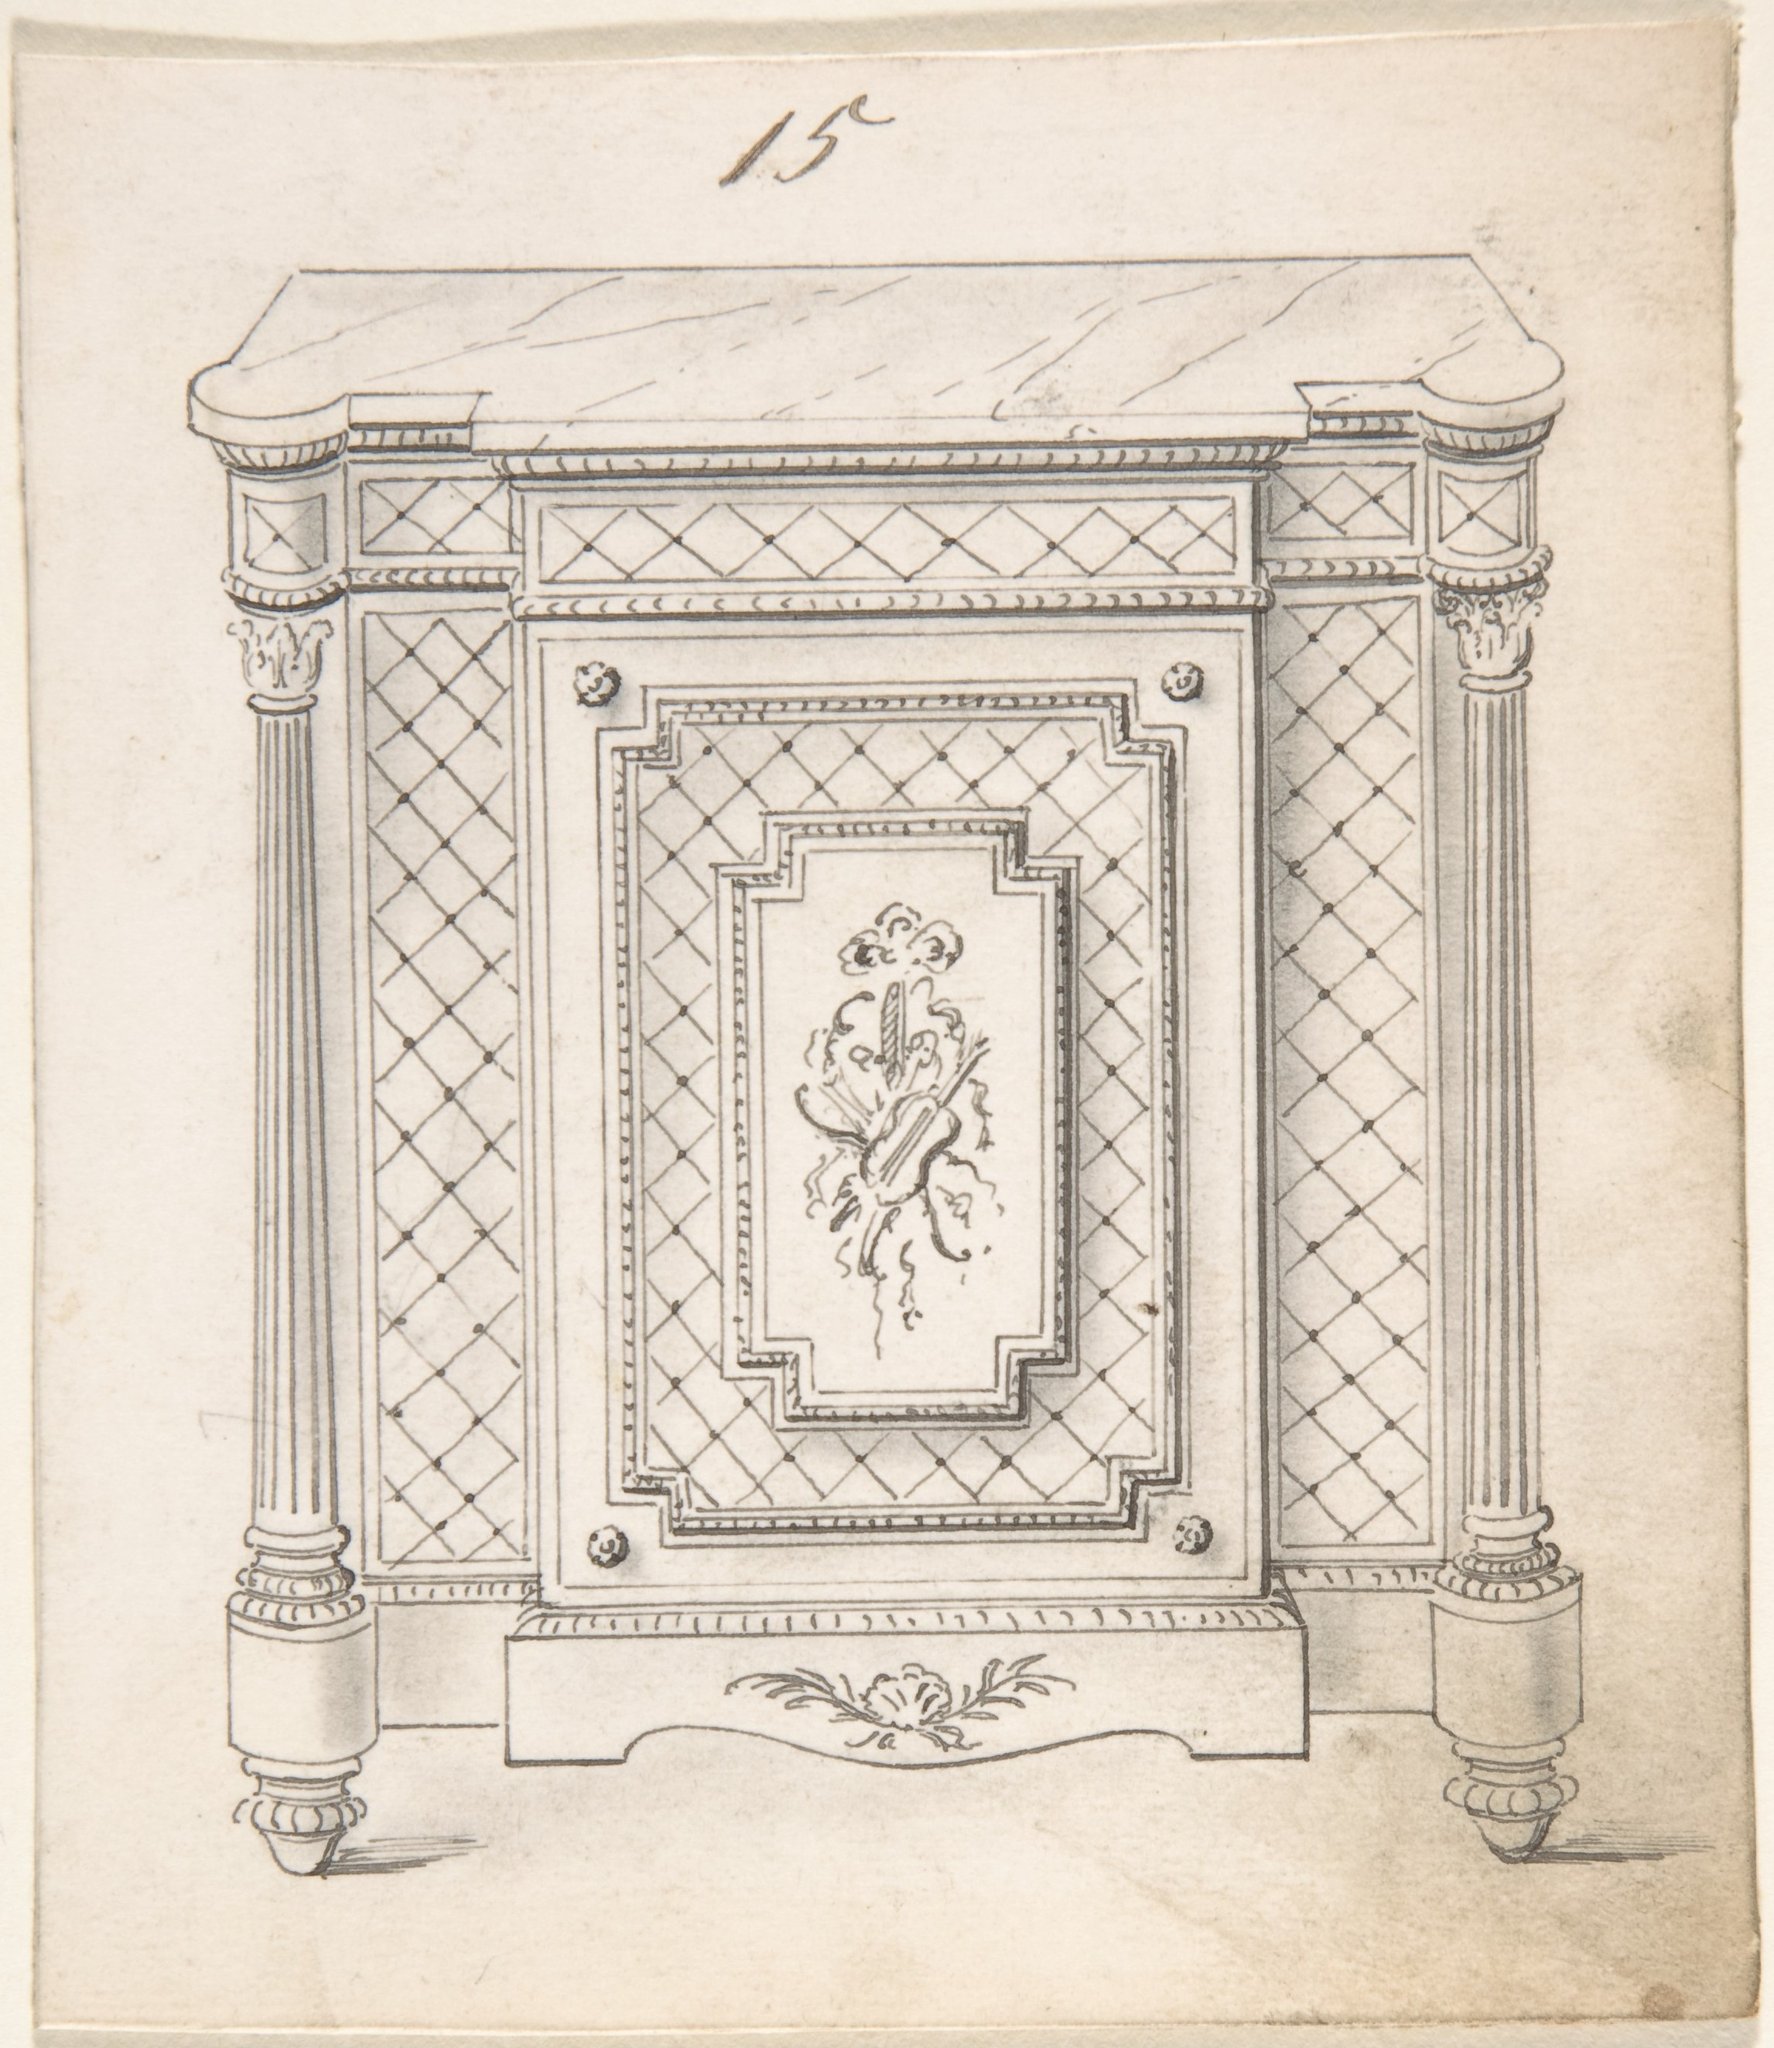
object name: drawing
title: Design for a Marble-topped Cabinet with Musical Ornament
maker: anonymous, british, 19th century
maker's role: artist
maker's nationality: british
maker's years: 1800-1900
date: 1801-1900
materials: ink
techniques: pen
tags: cabinets